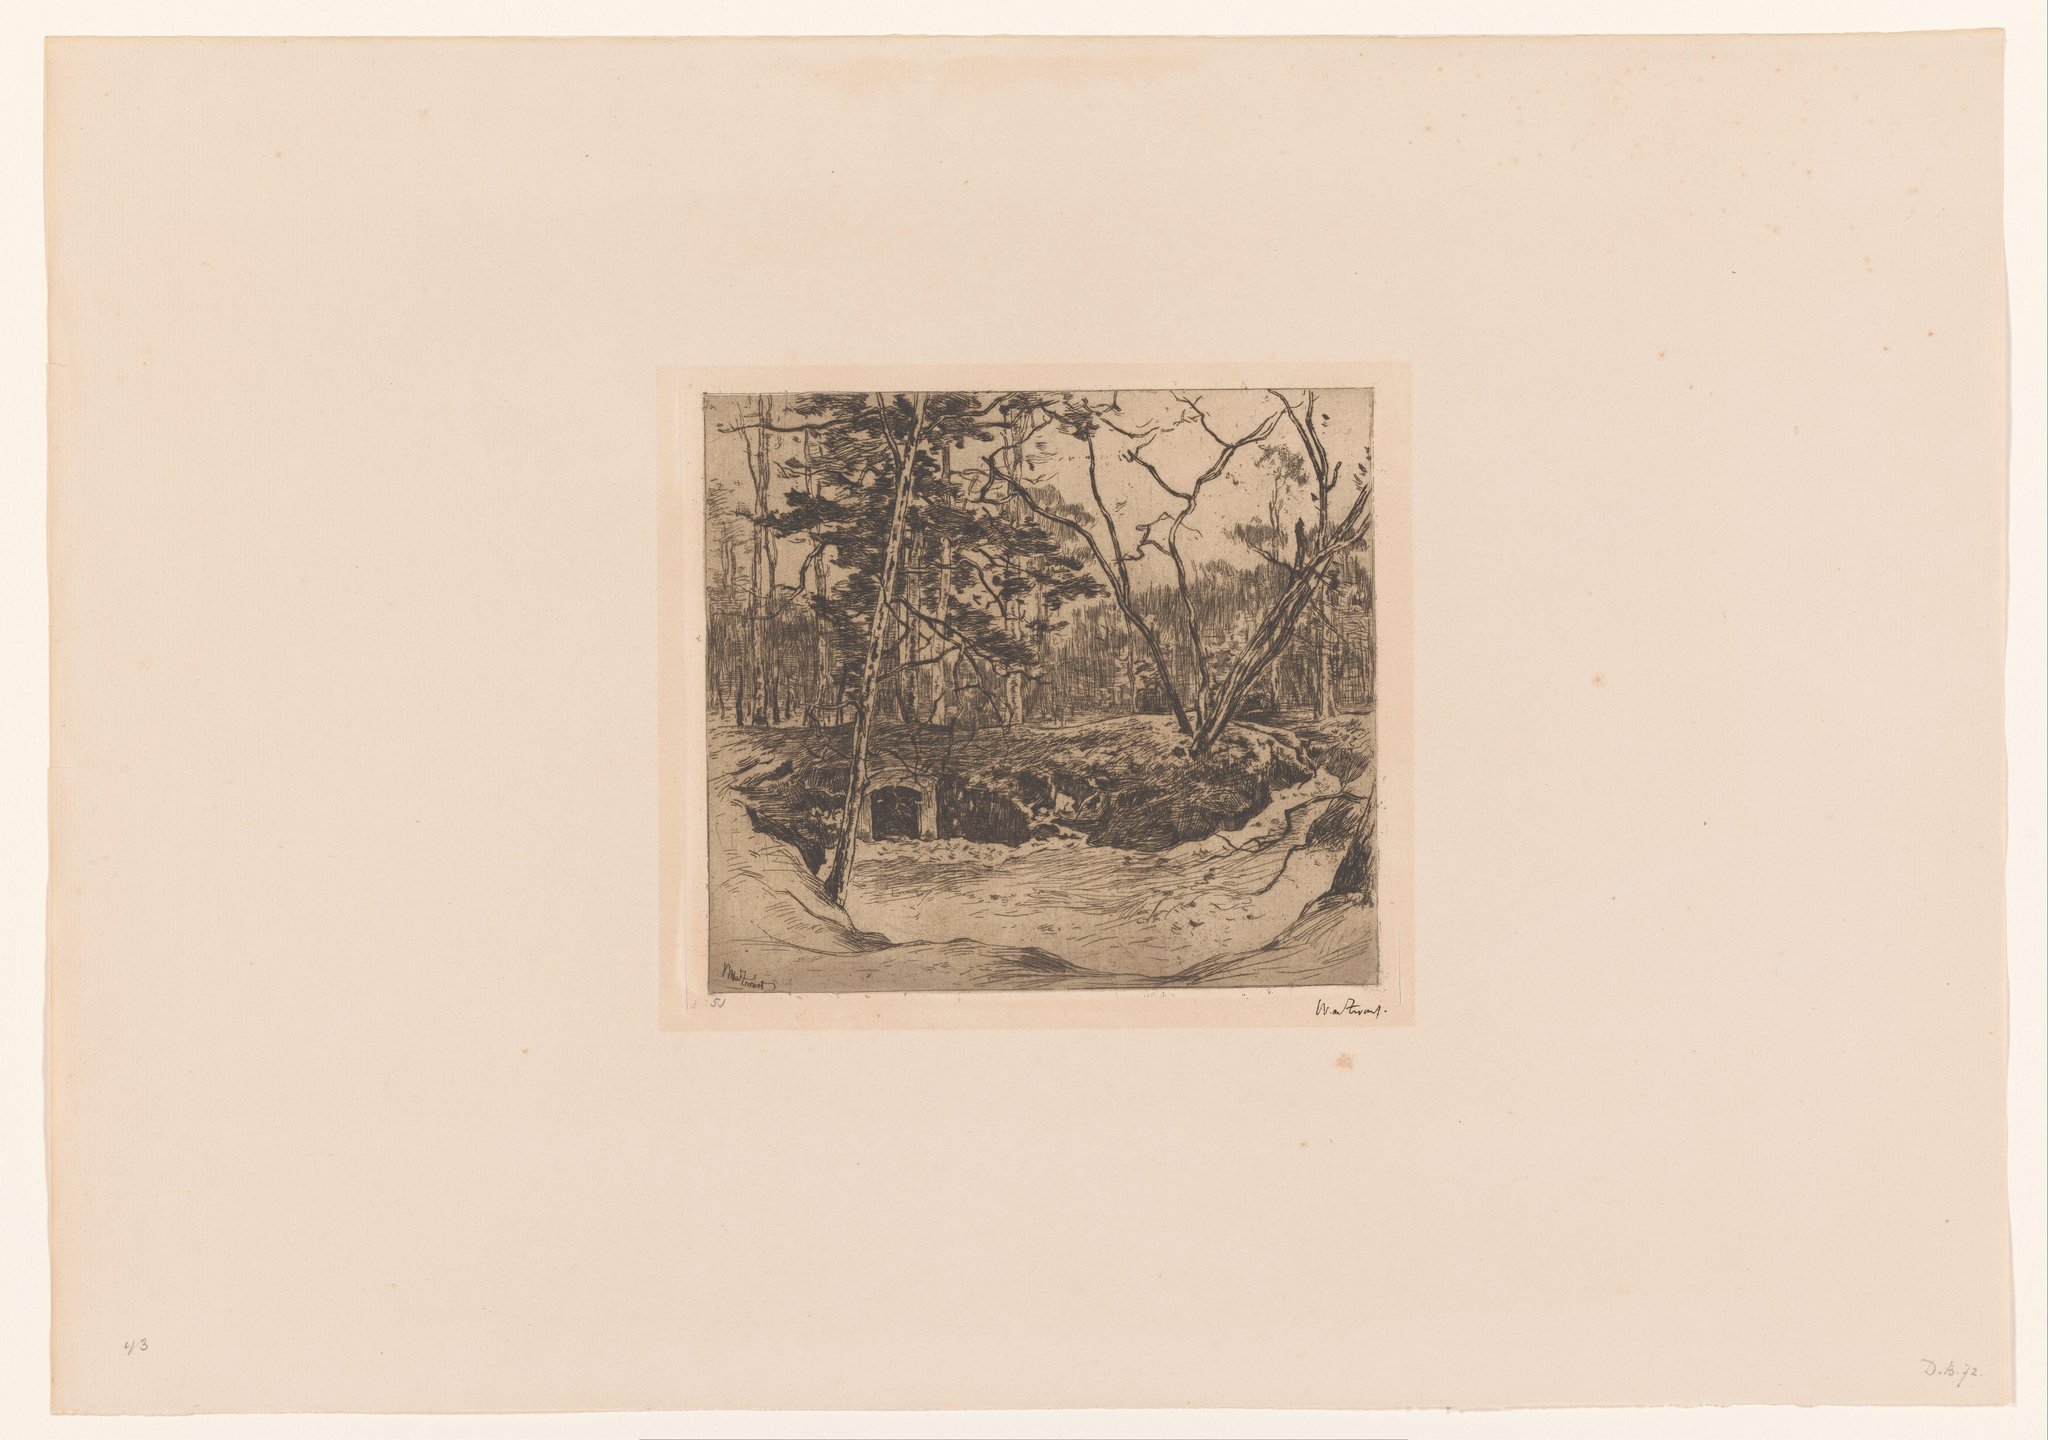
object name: print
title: Bos met ingang naar schuilkelder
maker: willem de zwart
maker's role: draughtsman, painter, print maker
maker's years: 1862-1931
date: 1872-1931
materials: paper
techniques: drypoint, etching, intaglio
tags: landscape with ruins, forest, wood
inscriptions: collector's mark: Lugt 2228